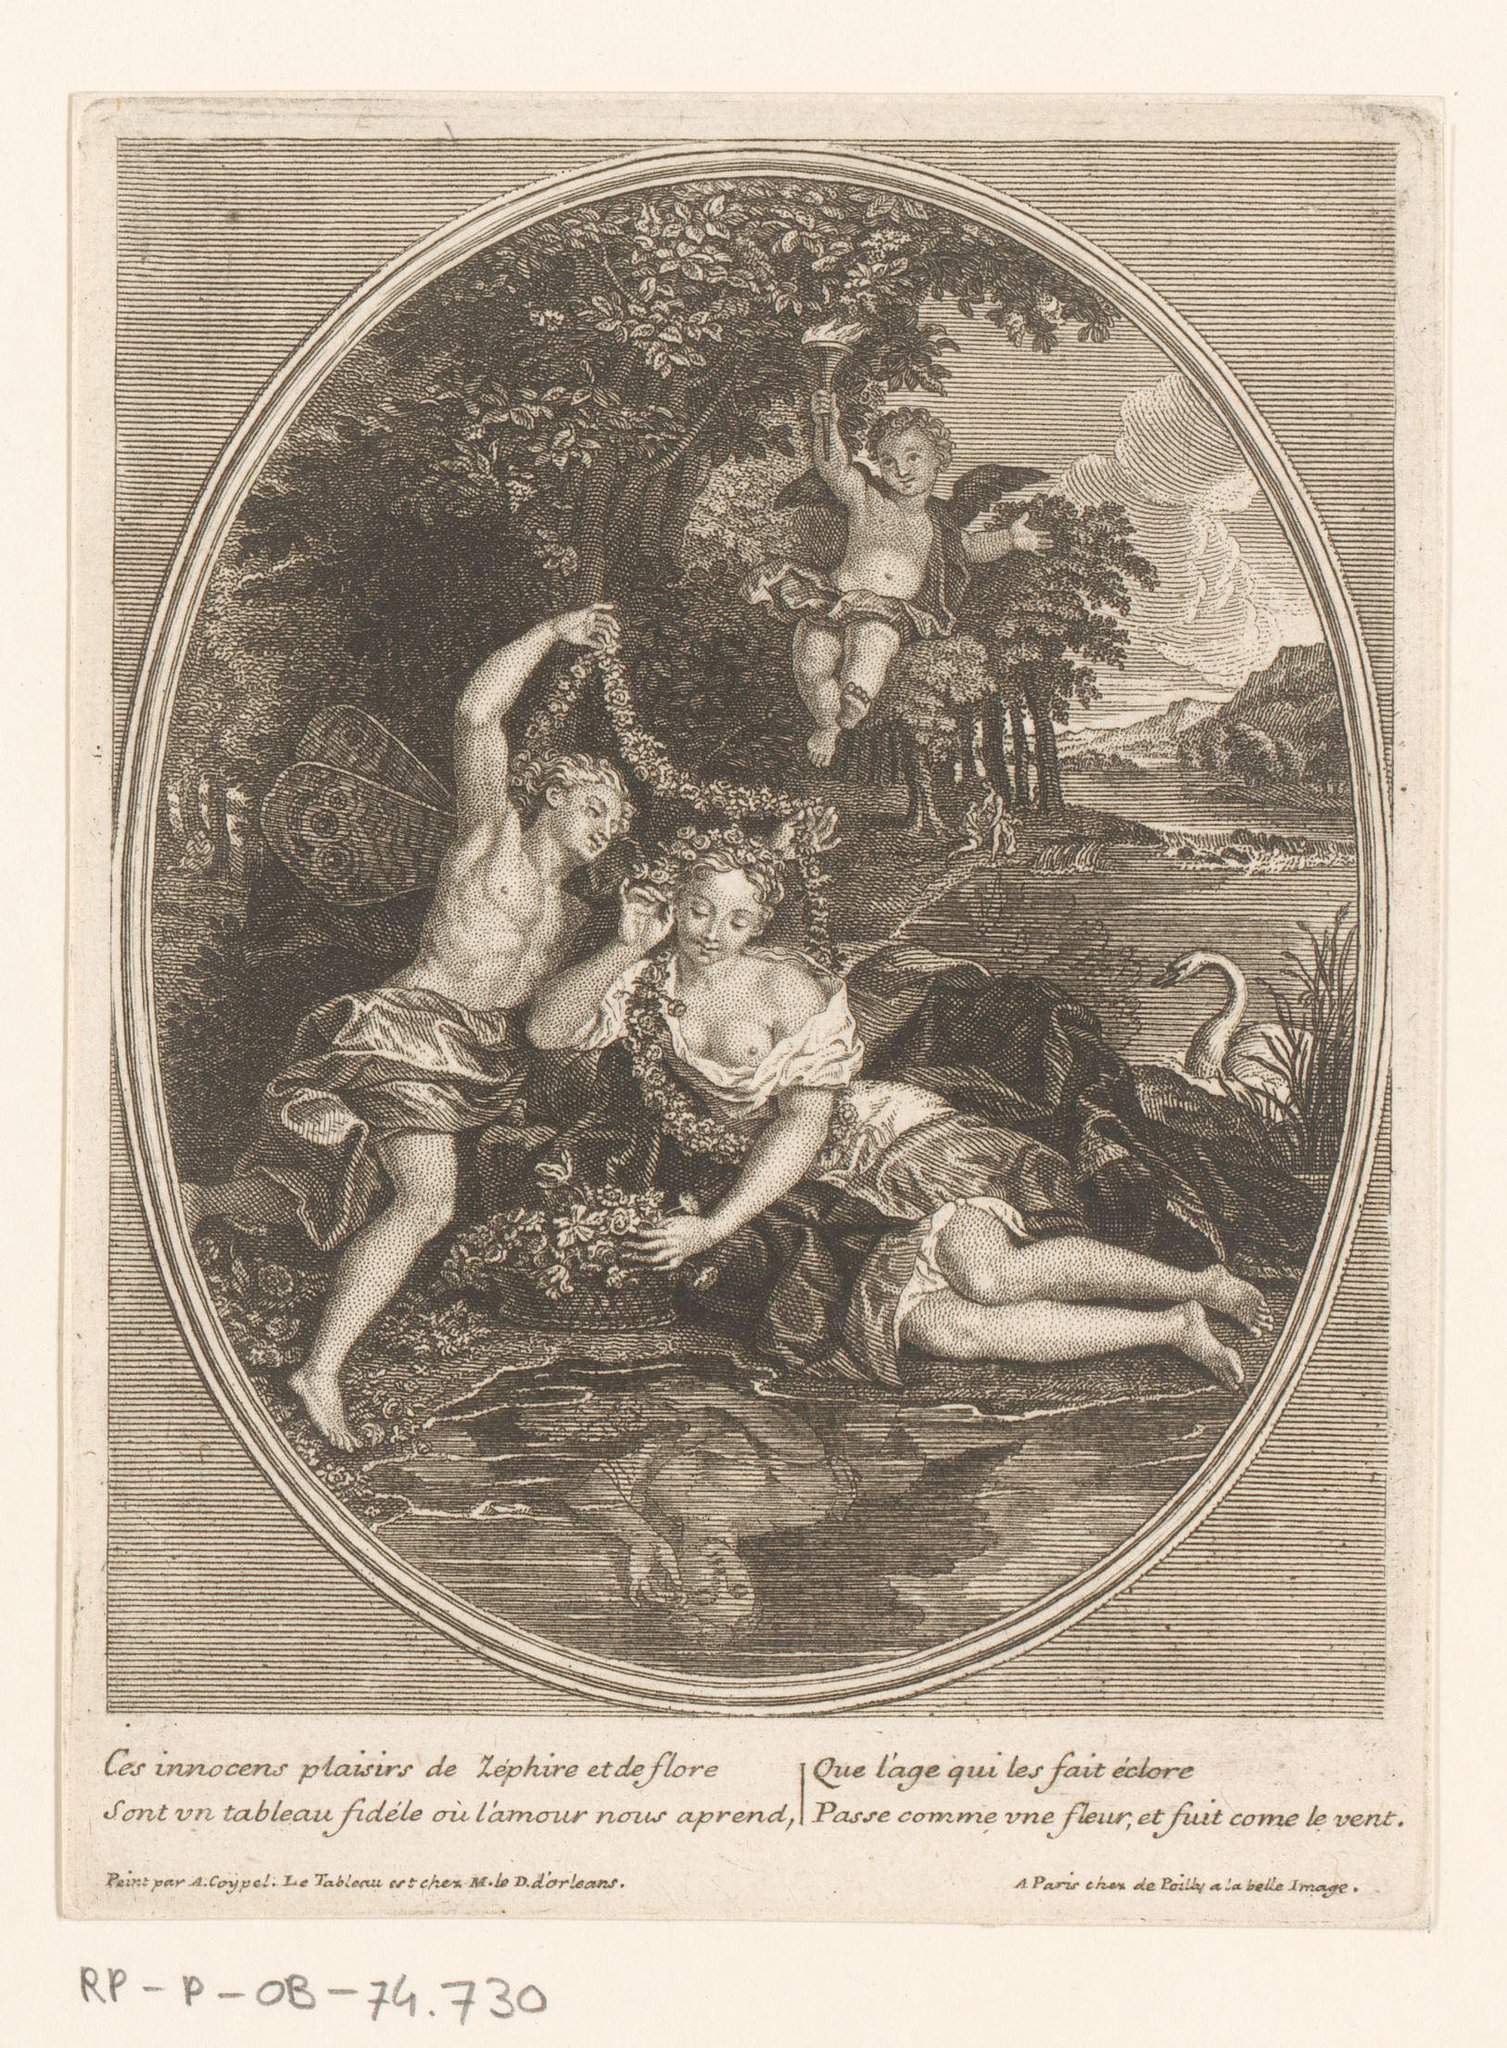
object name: print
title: Zephirus en Flora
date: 1671-1696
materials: paper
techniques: etching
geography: paris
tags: flora in her realm: a garden full of flowers, given to her by zephyrus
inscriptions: collector's mark: Lugt 2228